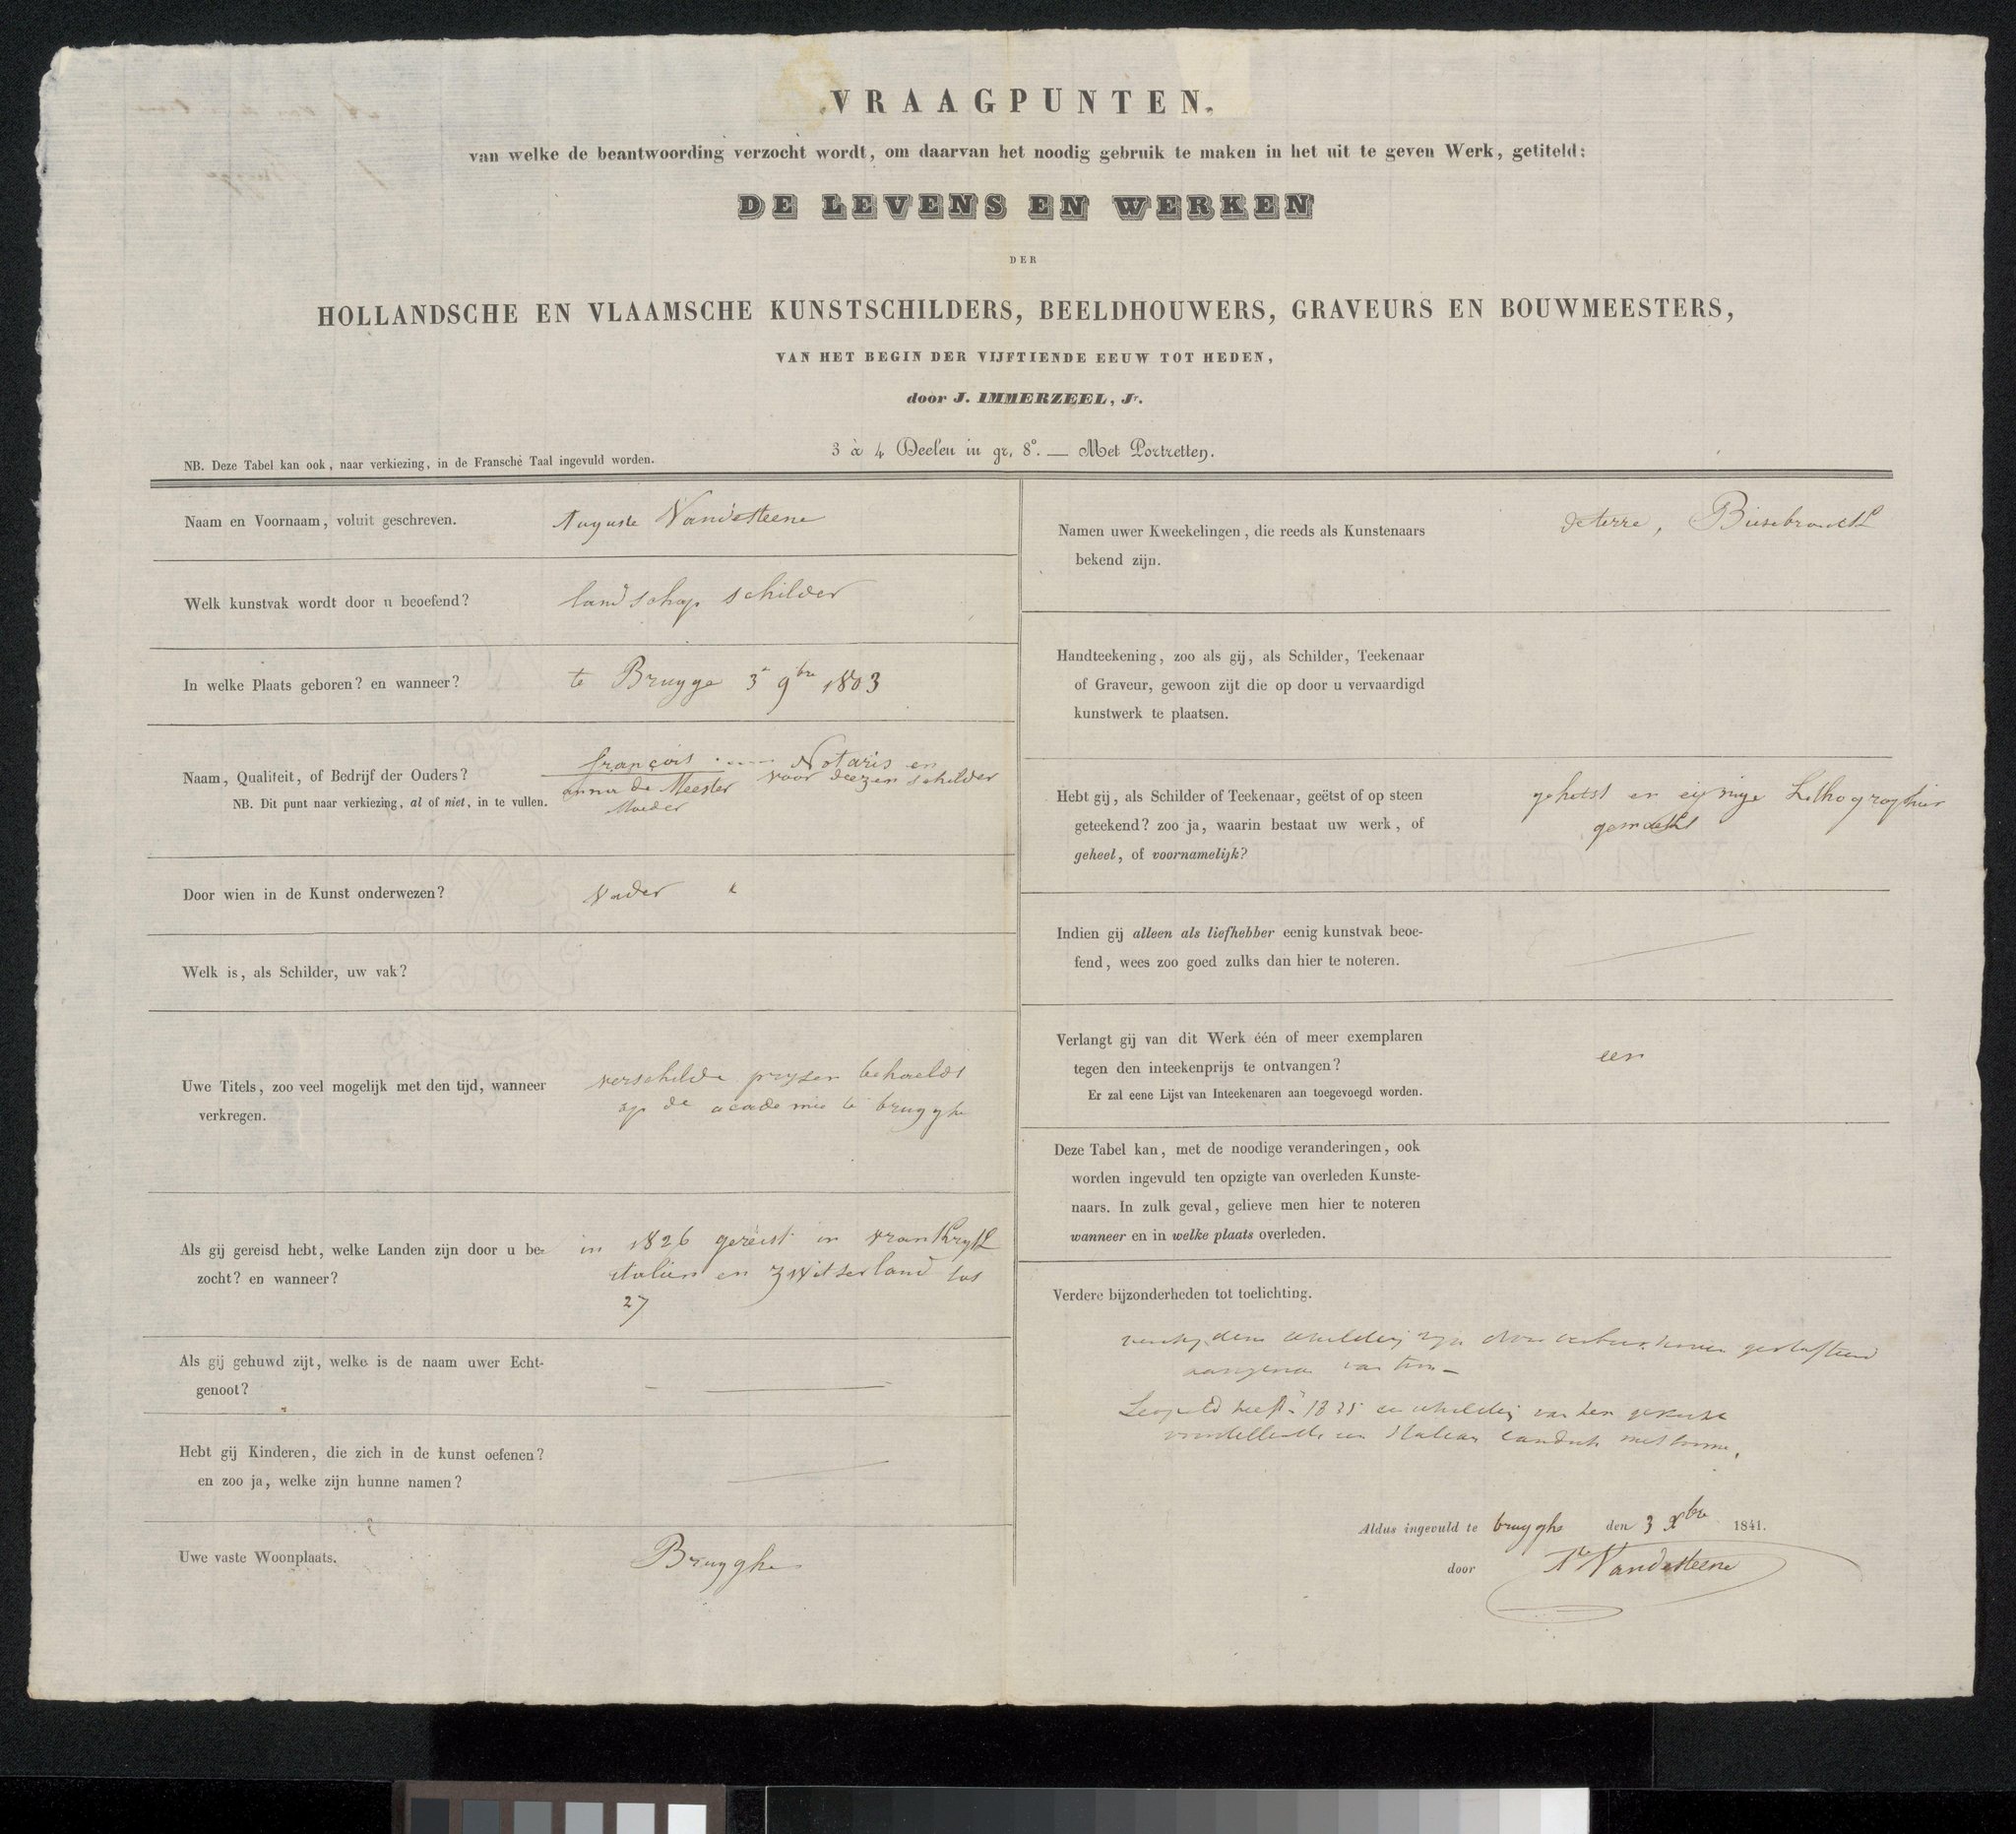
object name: manuscript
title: Enquêteformulier ingevuld door Augustus van der Steene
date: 1841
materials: ink, paper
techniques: pen, printing, writing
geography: bruges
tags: bruges, draughtsman, augustus van der steene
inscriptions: watermark, inscription: ‘Vraagpunten,/ van welke de beantwoording verzocht wordt, om daarvan het noodig gebruik te maken in het uit te geven Werk, getiteld: De levens en werken/ der Hollandsche en Vlaamsche kunstschilders, beeldhouwers,/ graveurs en bouwmeesters, van het begin der vijftiende eeuw tot heden/ door J. Immerzeel, Jr.’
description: Opgenomen in: Immerzeel, J. Jr., De levens en werken der Hollandsche en Vlaamsche kunstschilders, beeldhouwers, graveurs en bouwmeesters, van het begin der vijftiende eeuw tot heden, Amsterdam: J.C. van Kesteren, 1842-1843.